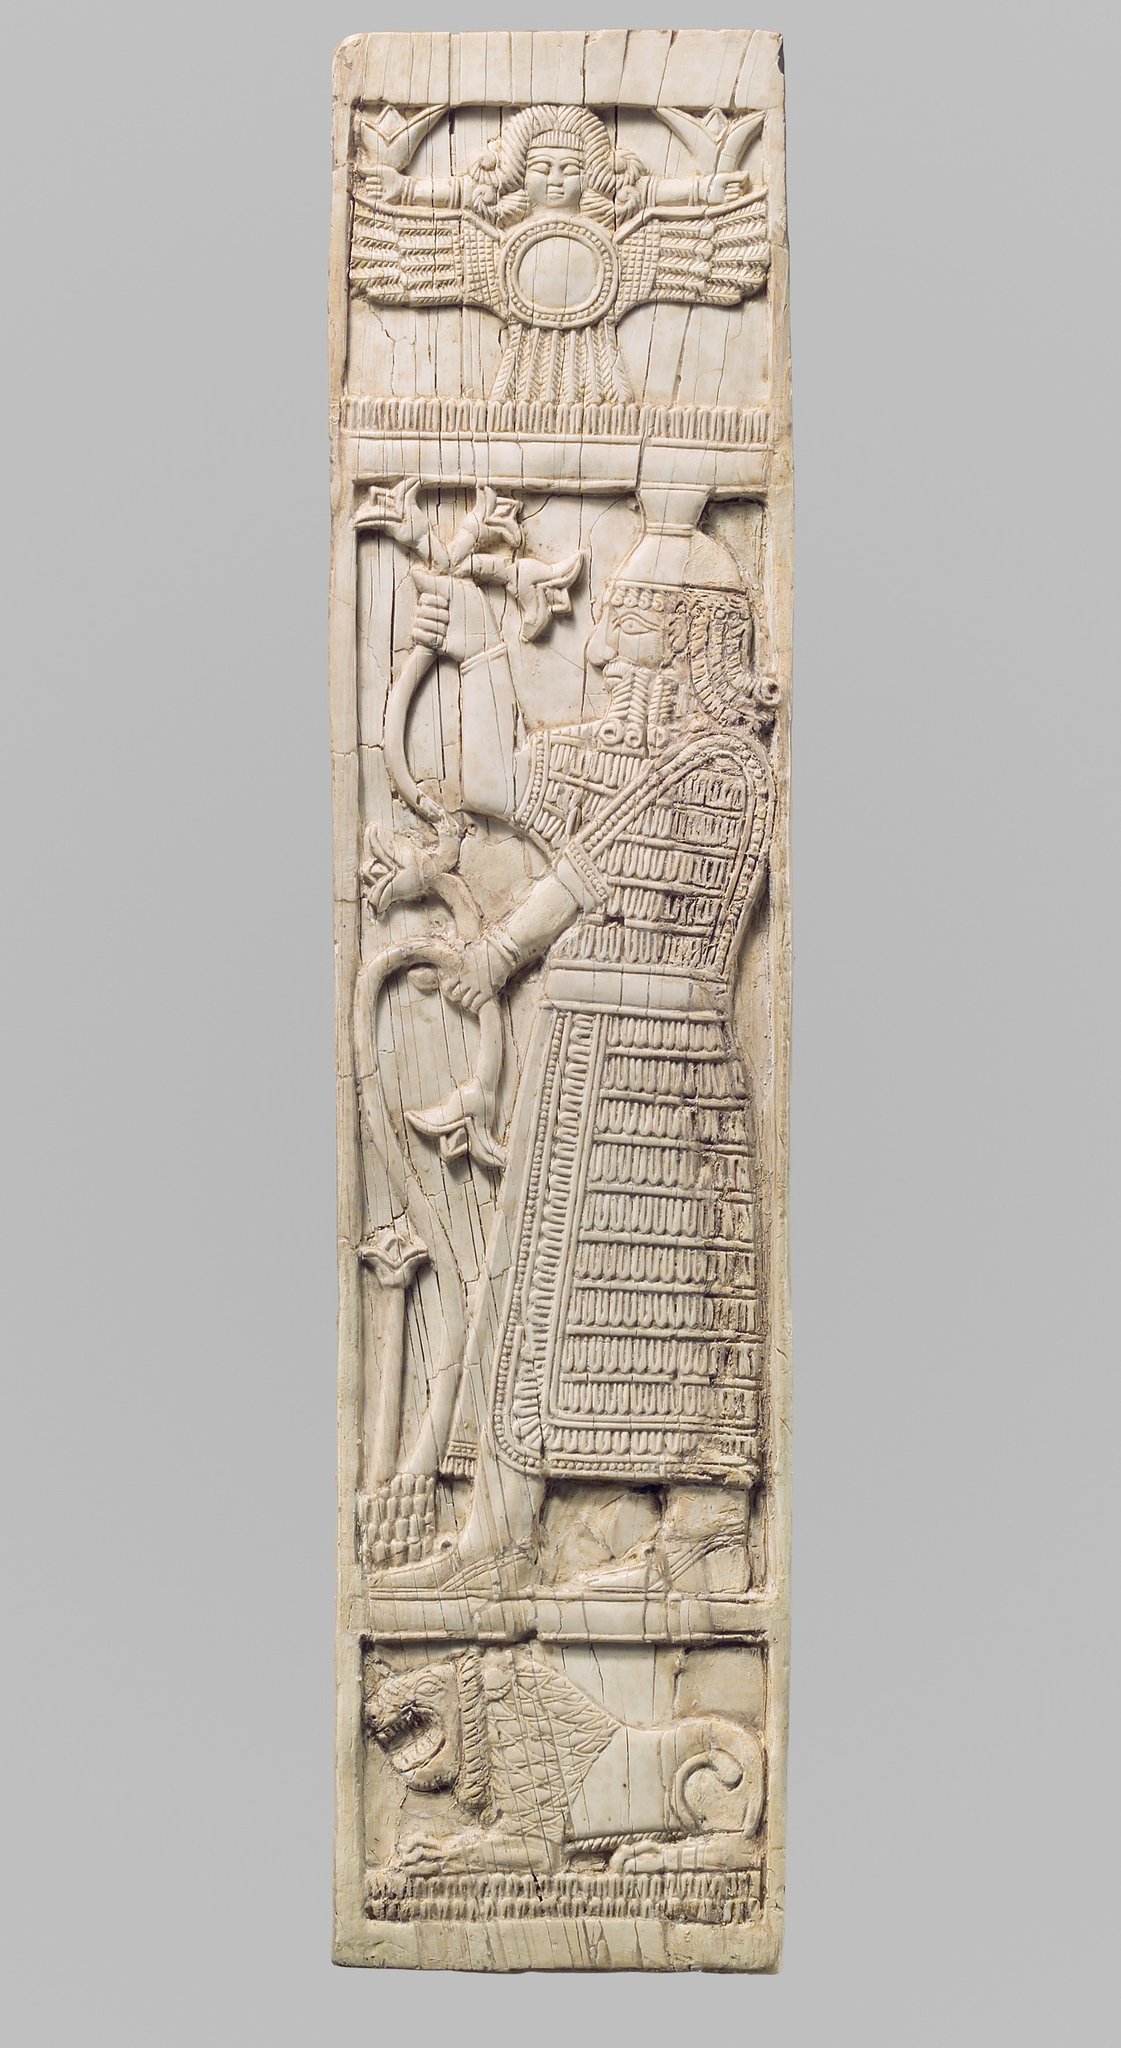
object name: relief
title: Furniture plaque carved in relief with warrior holding lotuses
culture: assyrian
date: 800-701 BCE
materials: ivory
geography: mesopotamia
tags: men,lions,lotuses